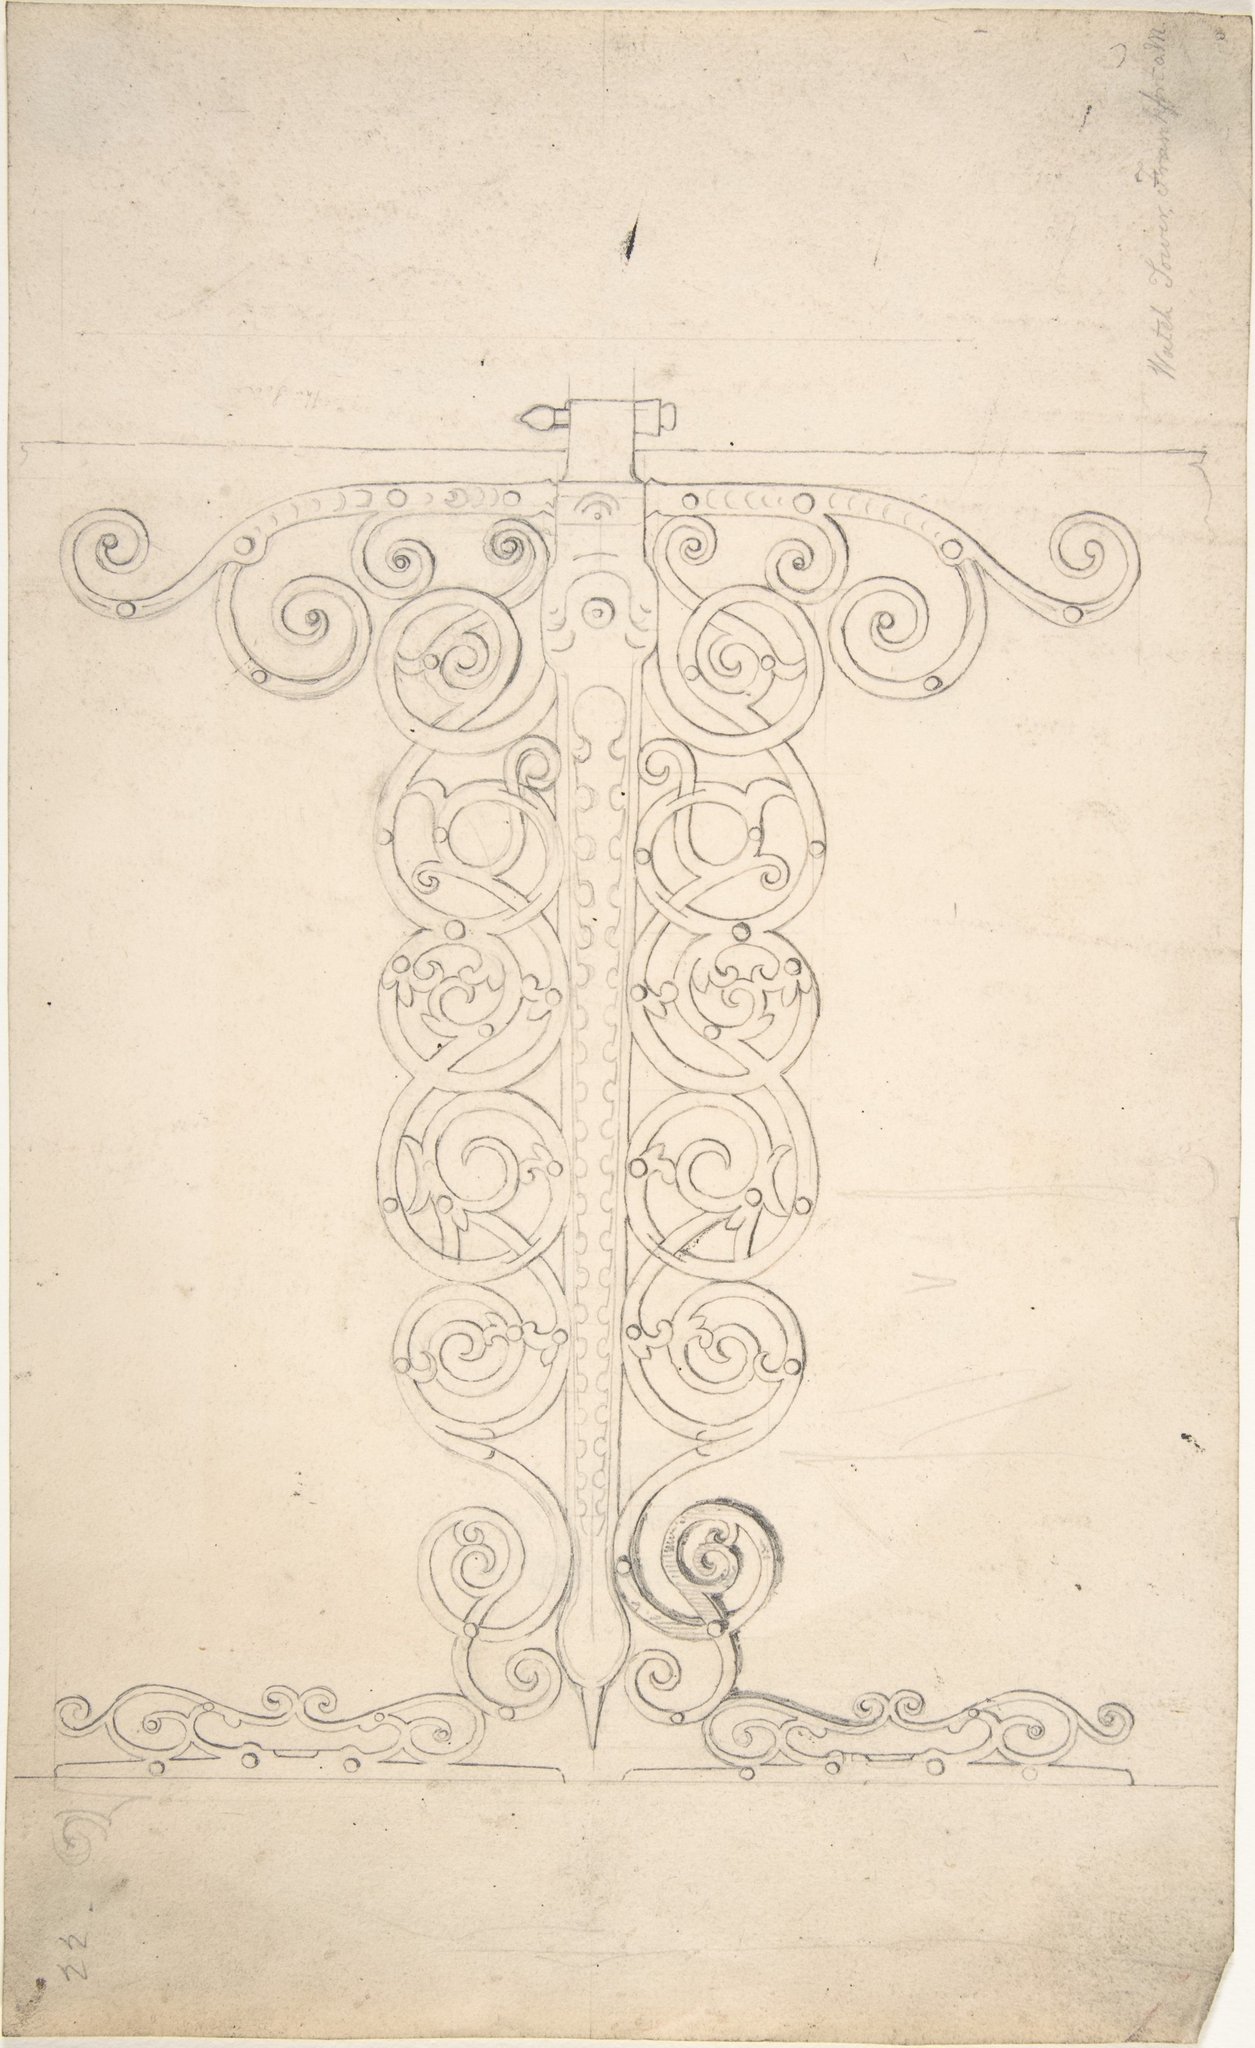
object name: drawing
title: Ornamented Metal Hinge from Watch Tower, Frankfurt am Main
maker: anonymous, british, 19th century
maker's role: artist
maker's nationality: british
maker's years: 1800-1900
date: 1851-1900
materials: graphite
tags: ornament